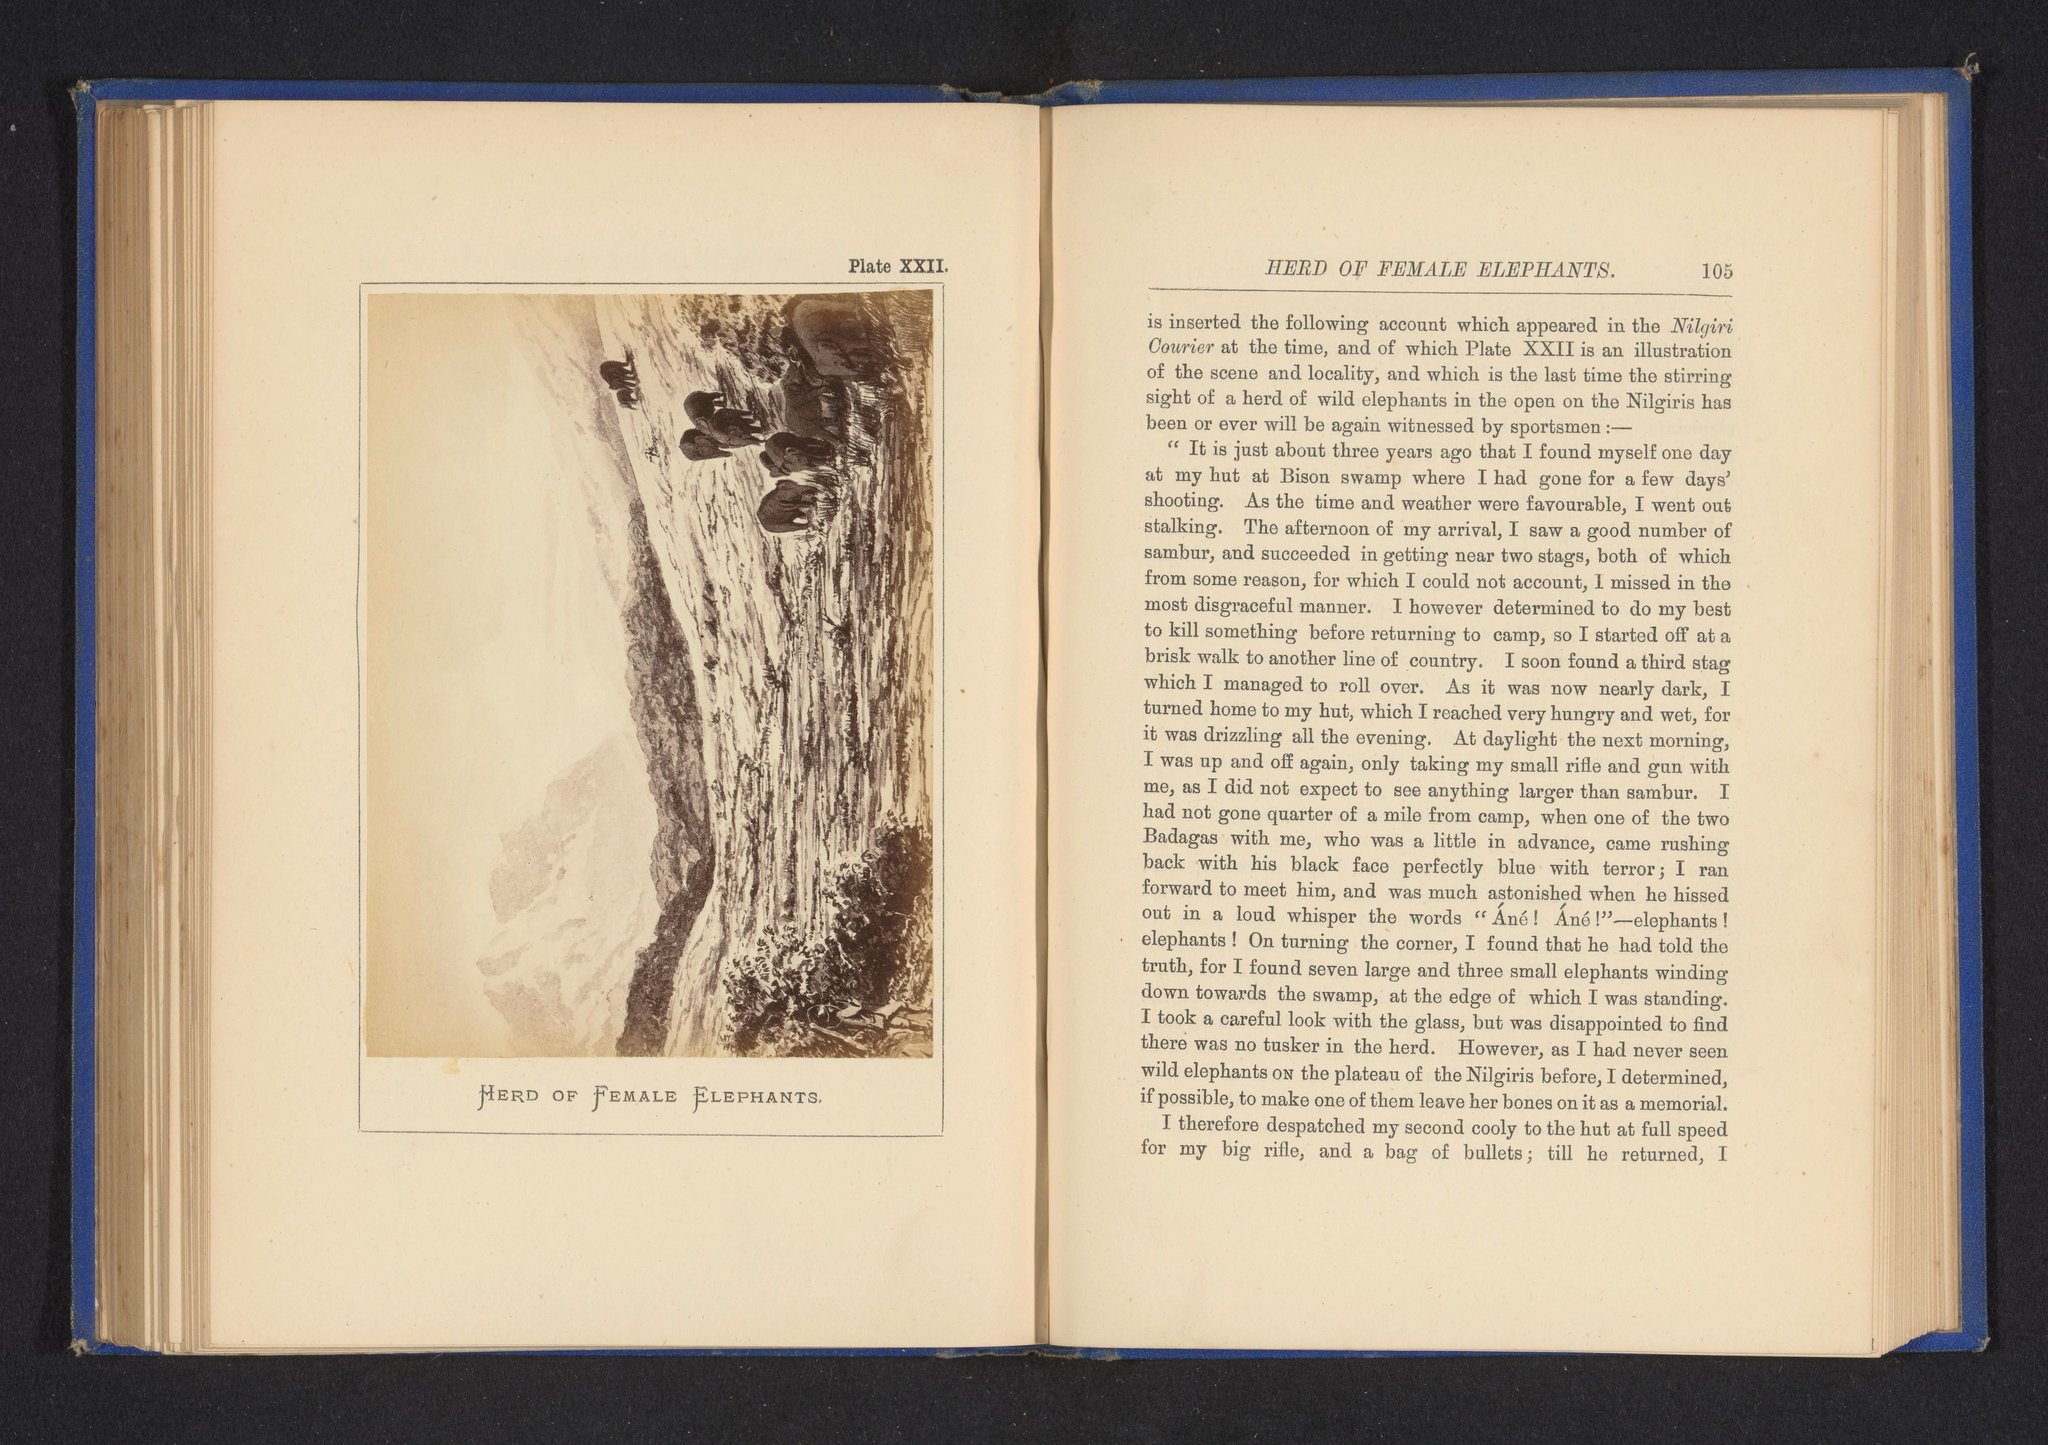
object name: photograph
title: Fotoreproductie van een tekening van een kudde olifanten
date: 1870-1880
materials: photographic support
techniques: albumen print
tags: drawing, sketch, trunked animals: elephant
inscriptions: number: ‘Plate XXII.’